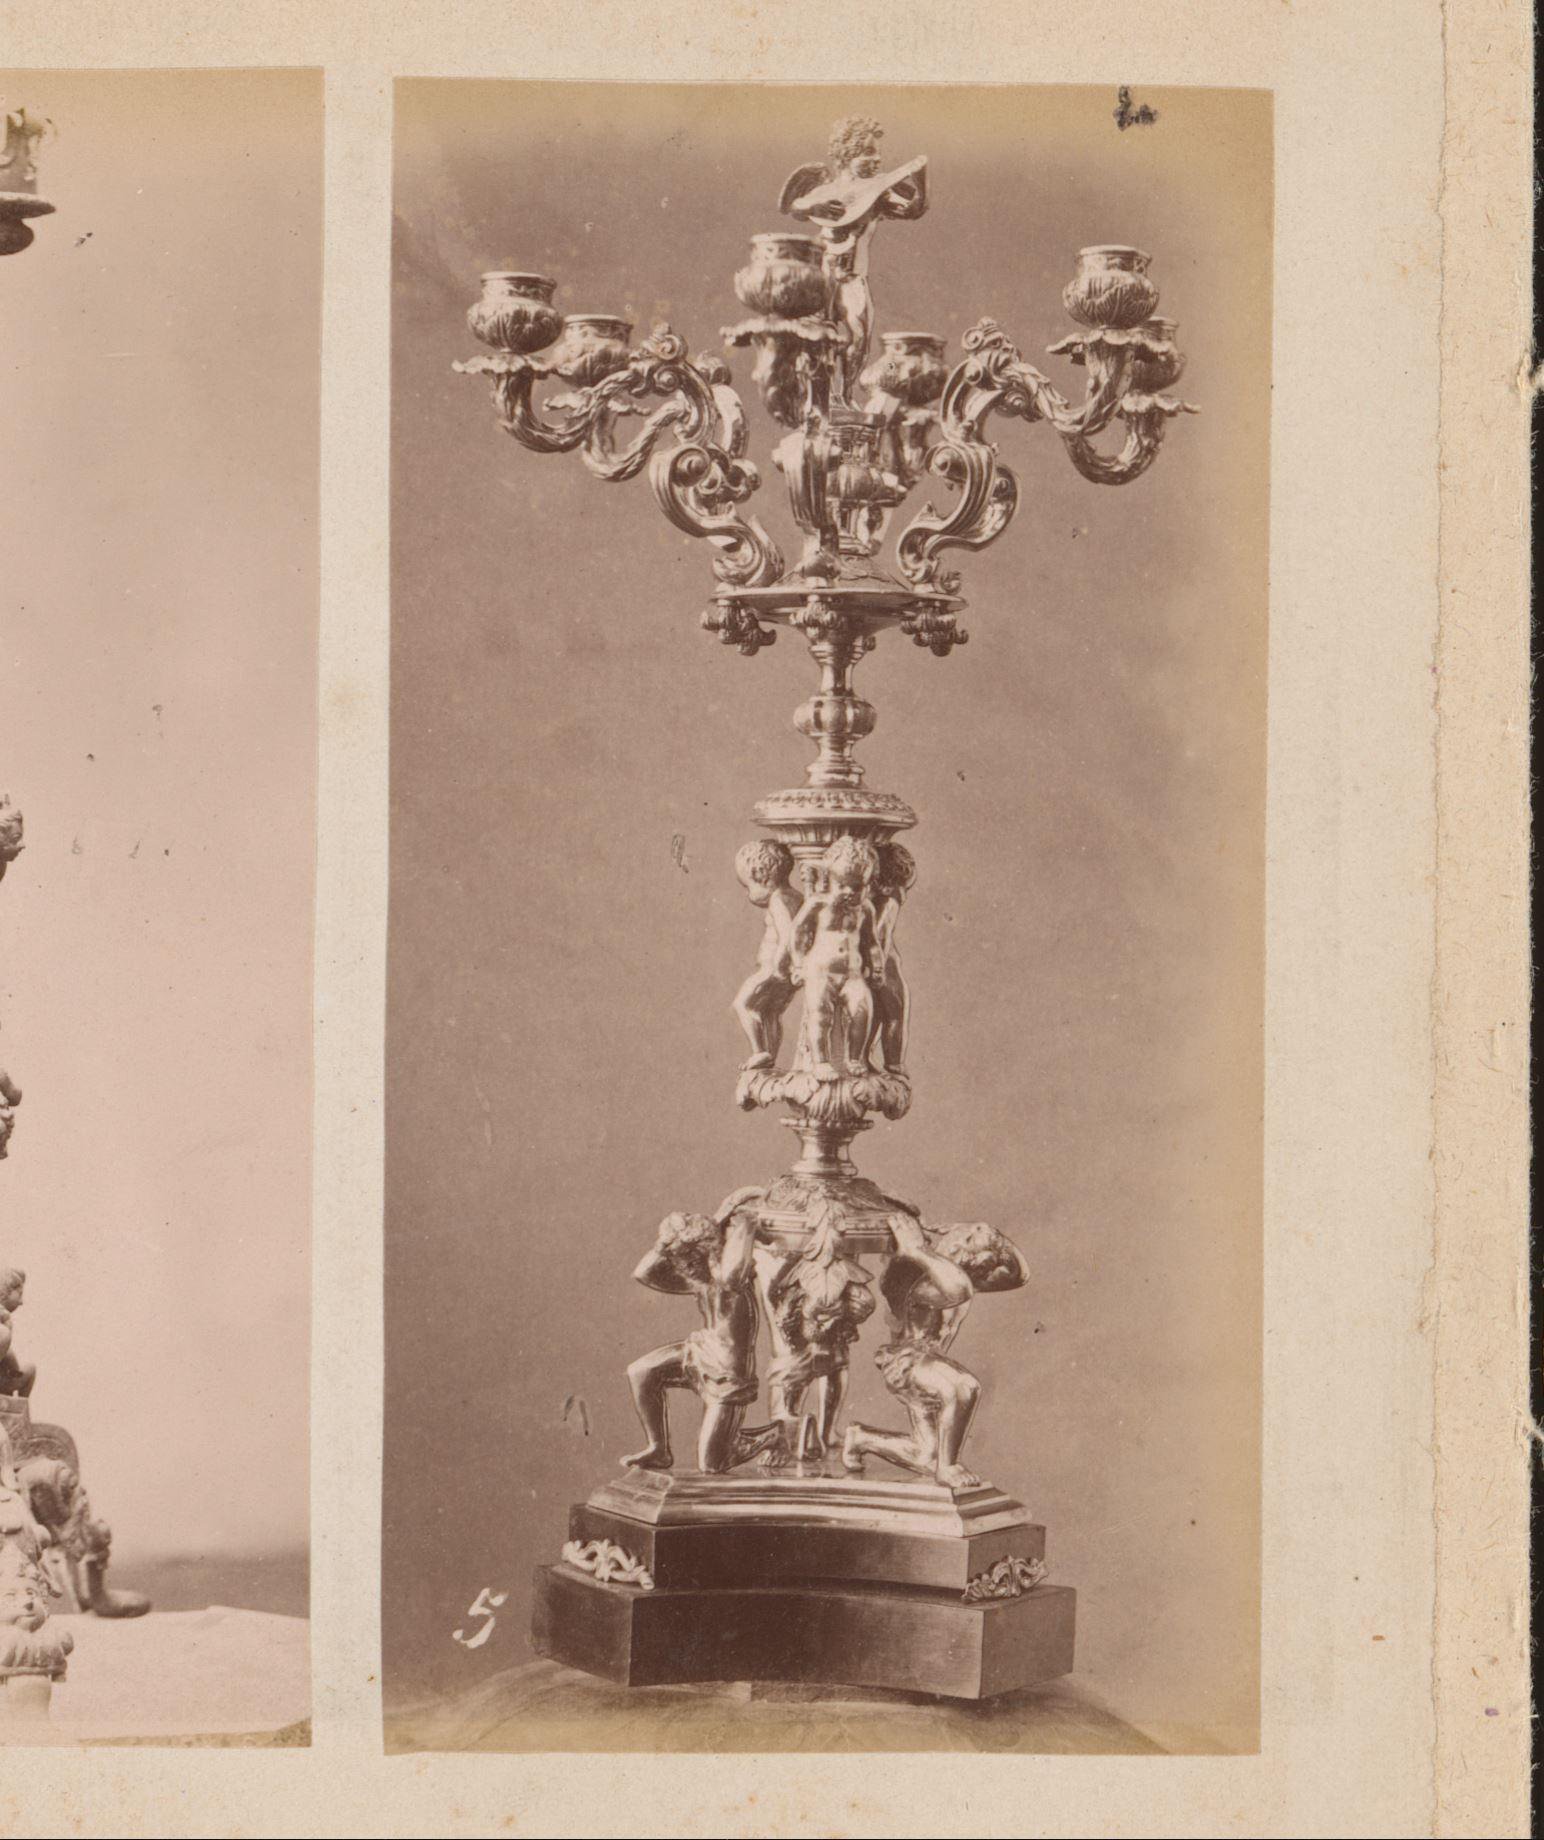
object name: page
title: Reuzenkandelaar voor gas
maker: Anonymous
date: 1860-1885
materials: photographic support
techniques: albumen print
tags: chandelier, candelabrum